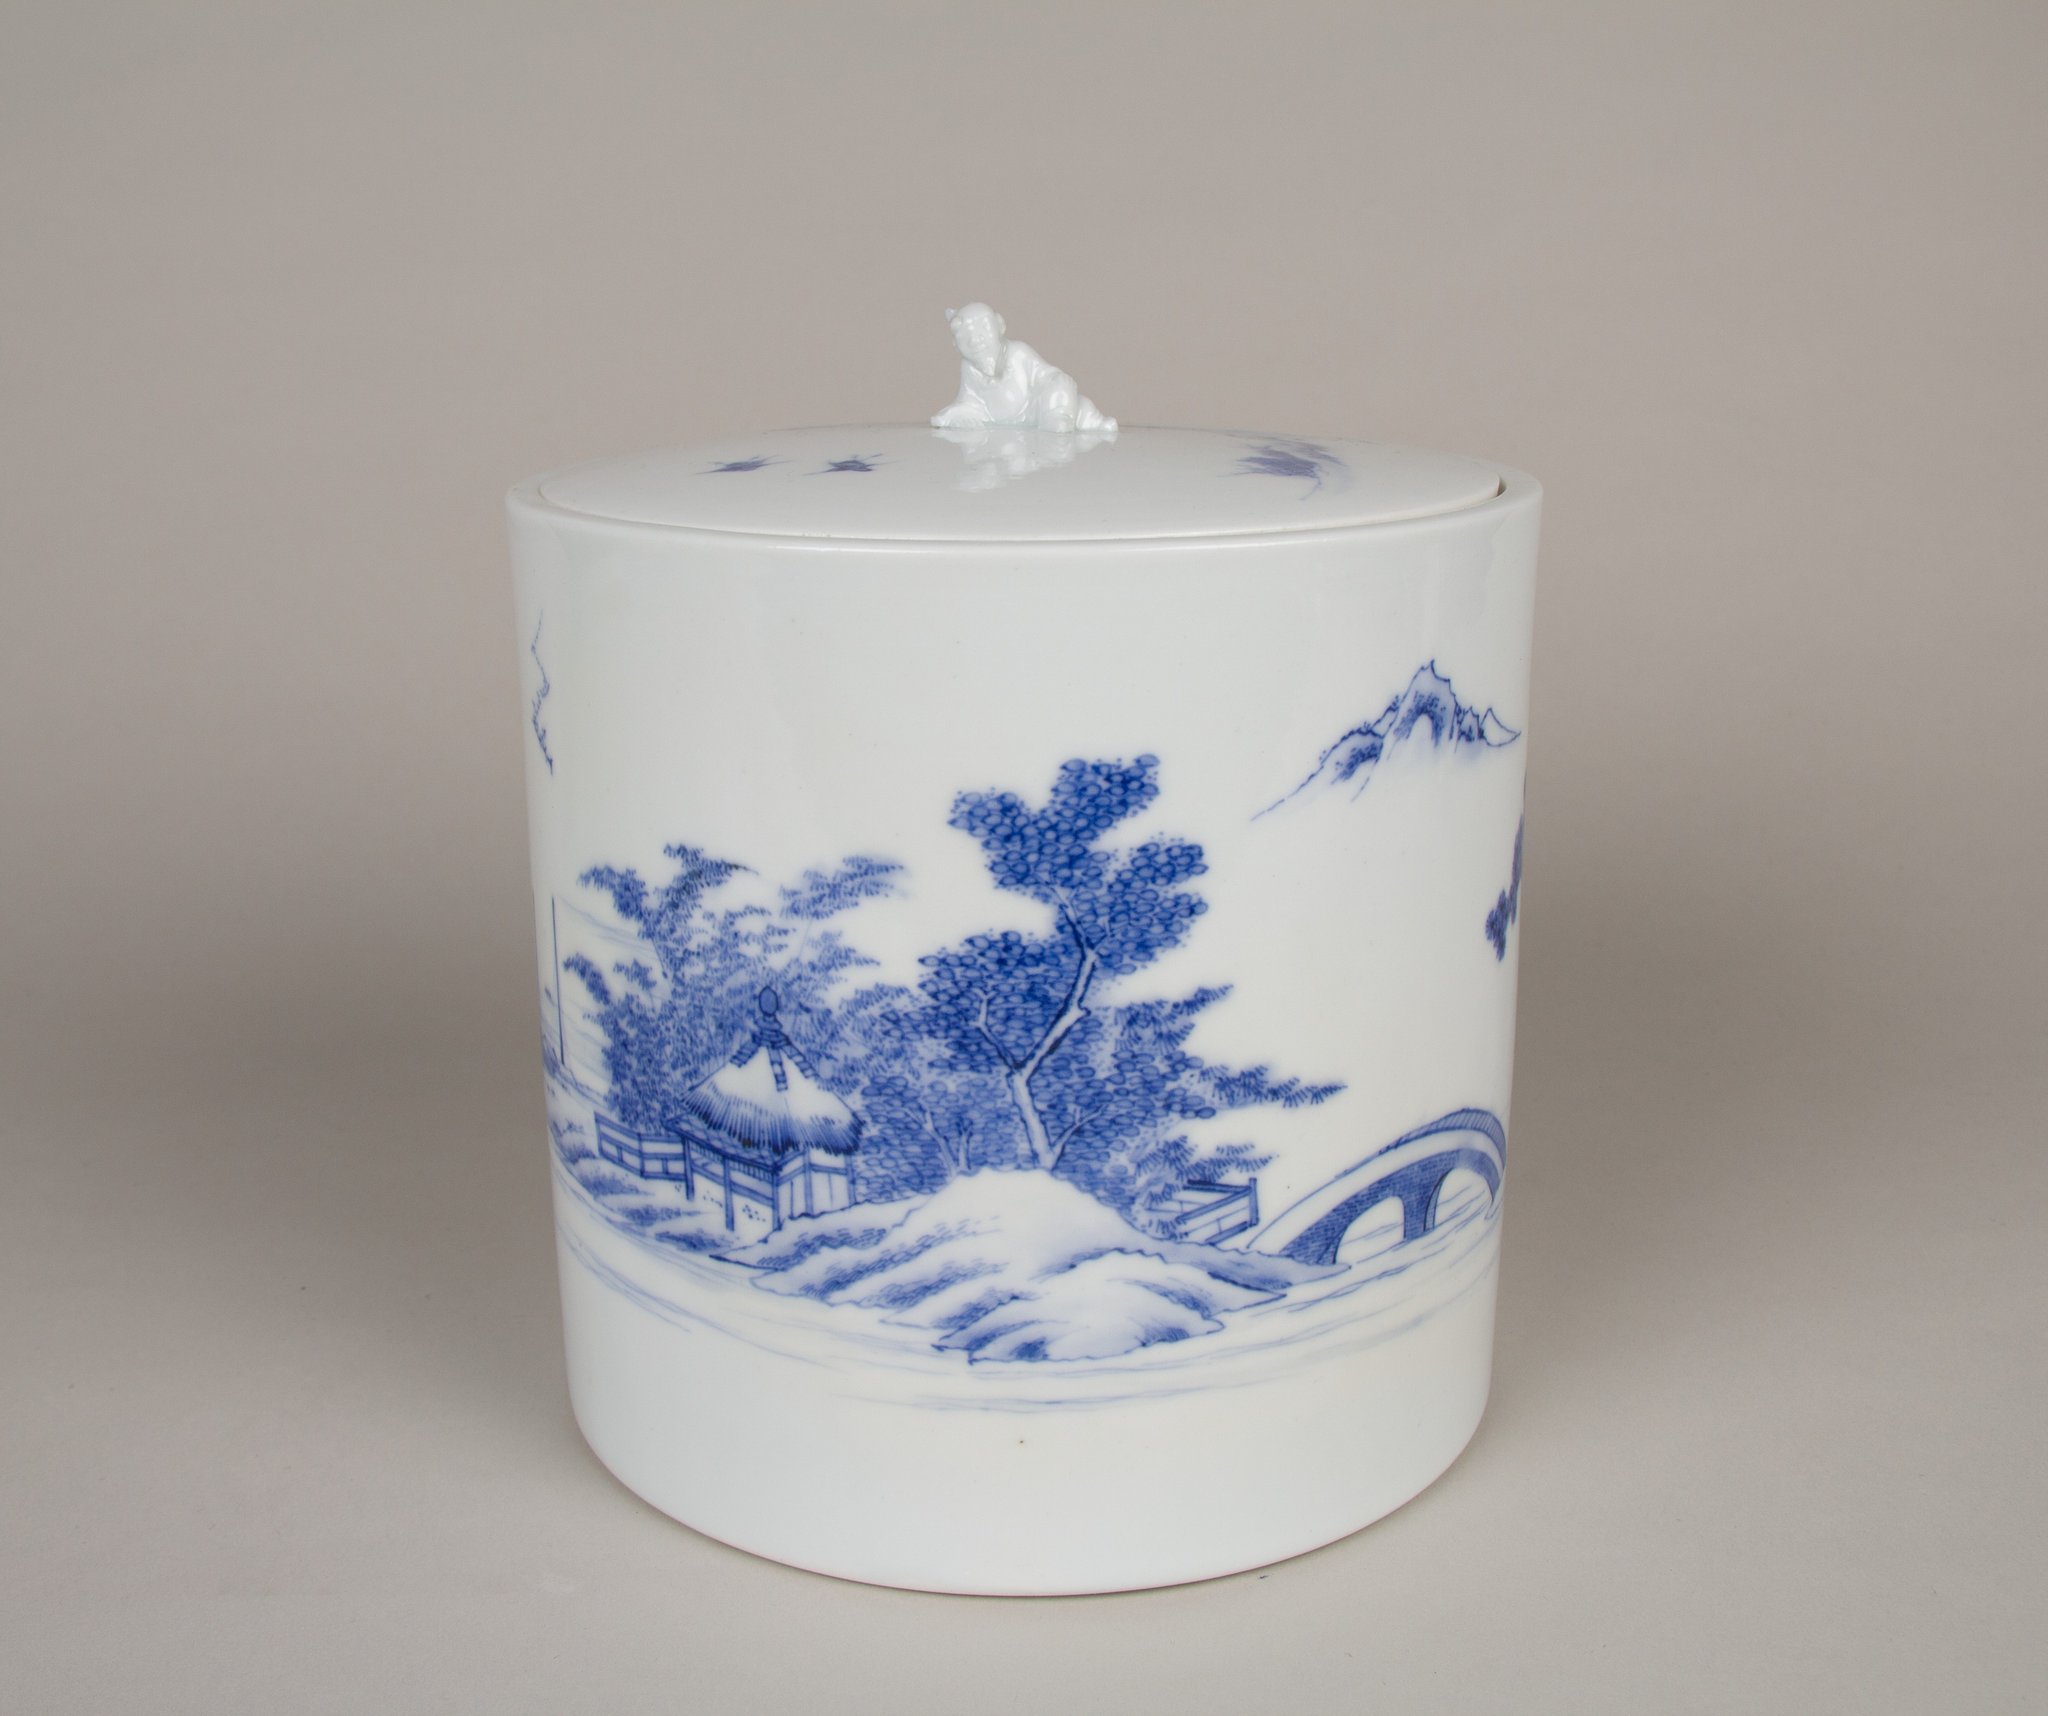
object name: water jar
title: Water Jar with Lin Hejing (Lin Bu) and His Pet Crane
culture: japanese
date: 1834-1866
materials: porcelain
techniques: underglaze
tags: houses,bridges,landscapes,trees